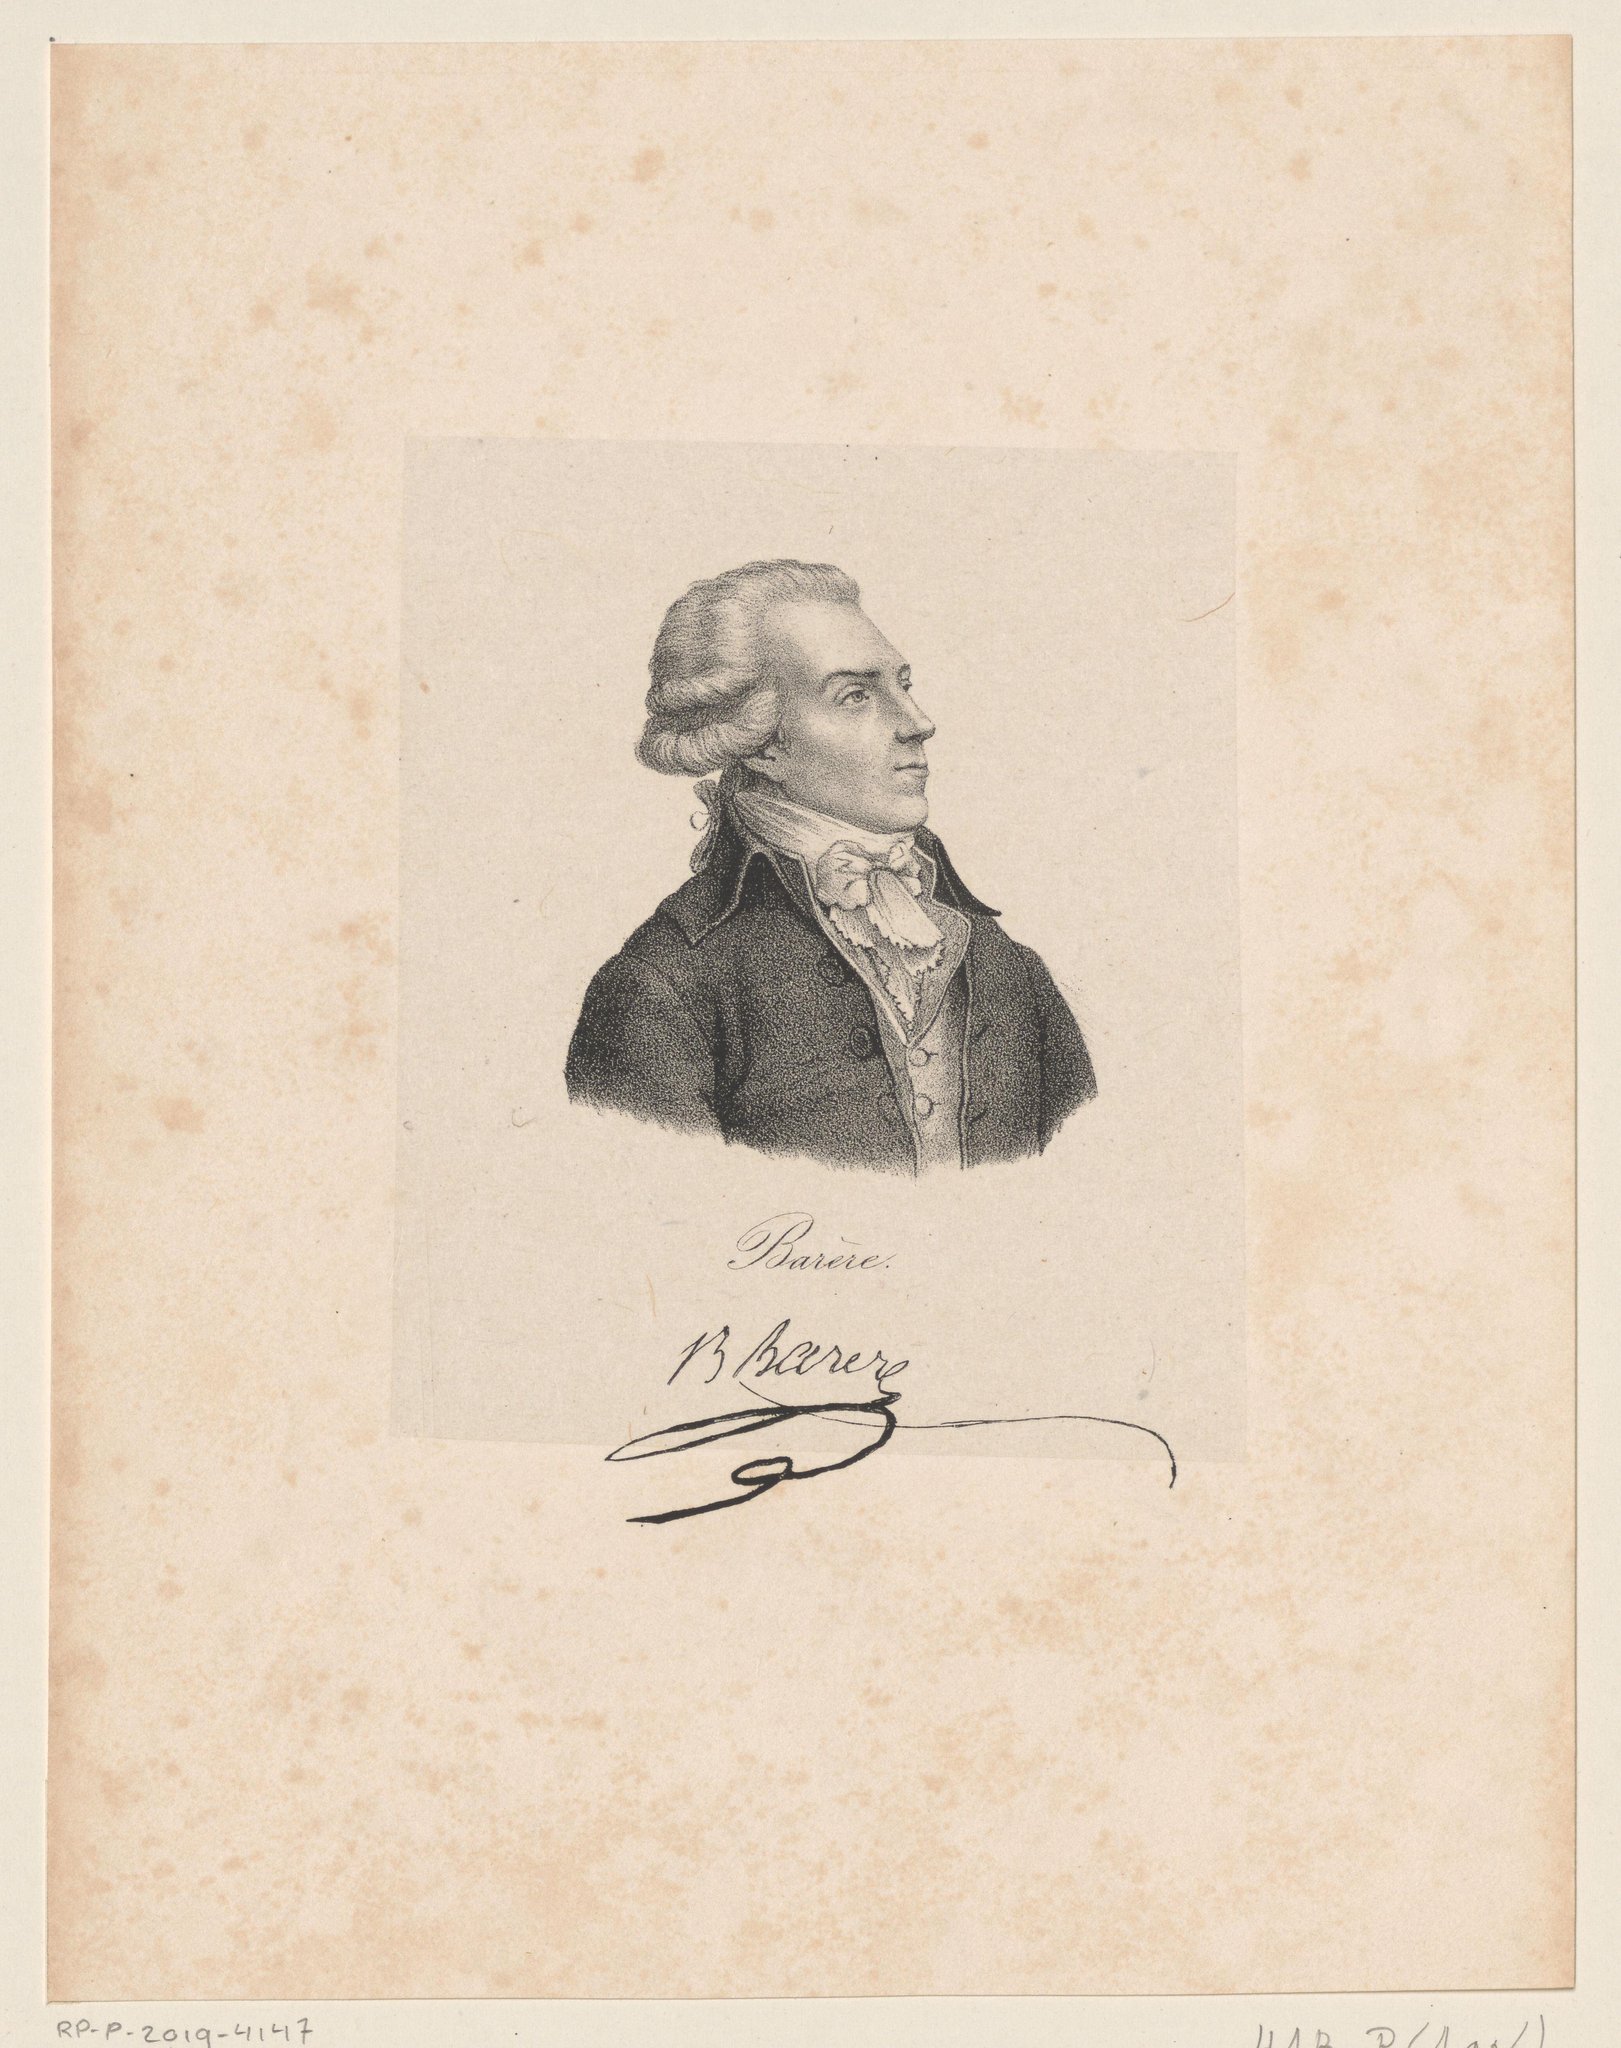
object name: print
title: Portret van Bertrand Barère de Vieuzac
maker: Anonymous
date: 1800-1849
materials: paper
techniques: lithograph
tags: politician, historical persons